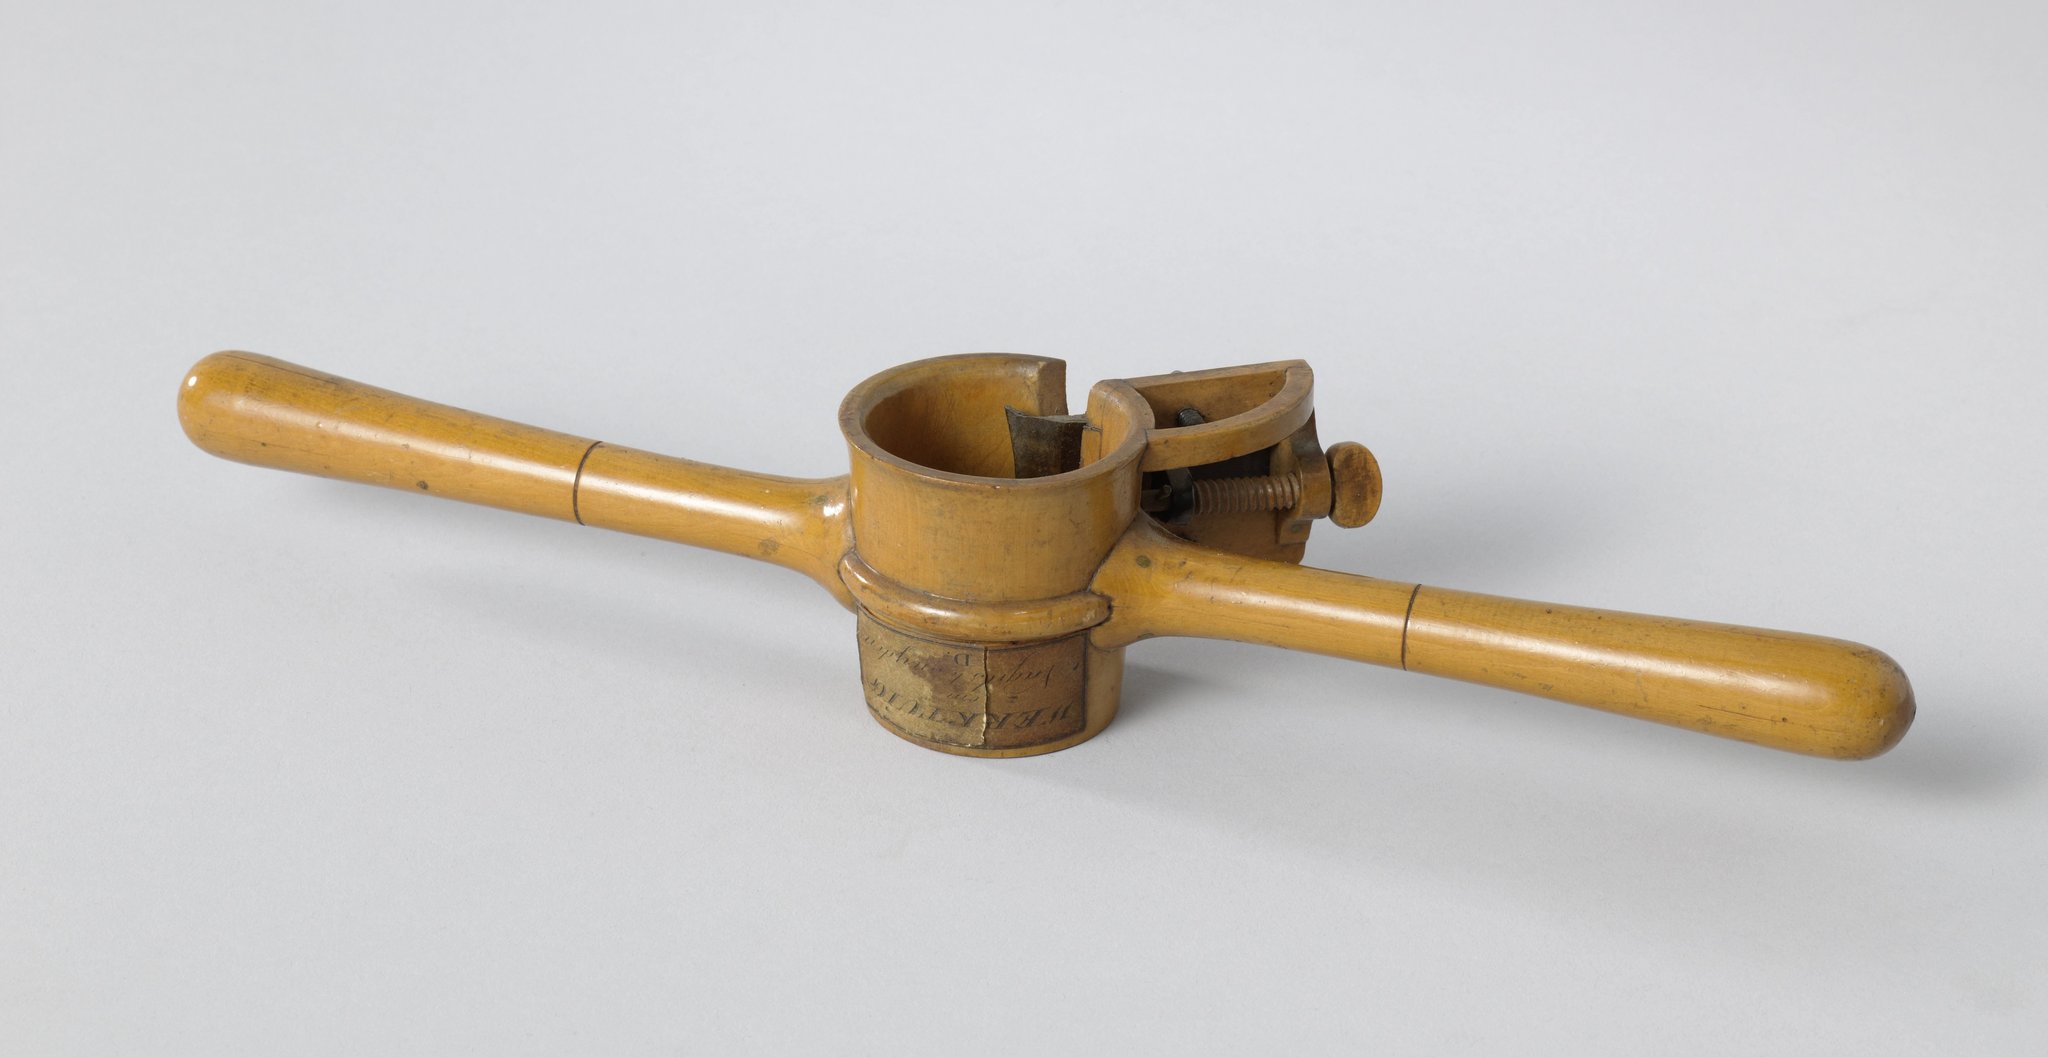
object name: demonstration model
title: Model of a Rounder Plane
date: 1819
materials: wood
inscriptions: inscription, on the front: ‘WERKTUiG / om / Nagels te snyden / D.’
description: Hoewel pennenschaven reeds lang gebruikt werden in Nederland, was dit type van Britse oorsprong en werd op Nederlandse werven ingevoerd in 1821. Dit model heeft de afmetingen van de schaaf voor nagels; die voor neuten was groter. Dit model vormde waarschijnlijk een serie samen met NG-MC-65 en NG-MC-70.